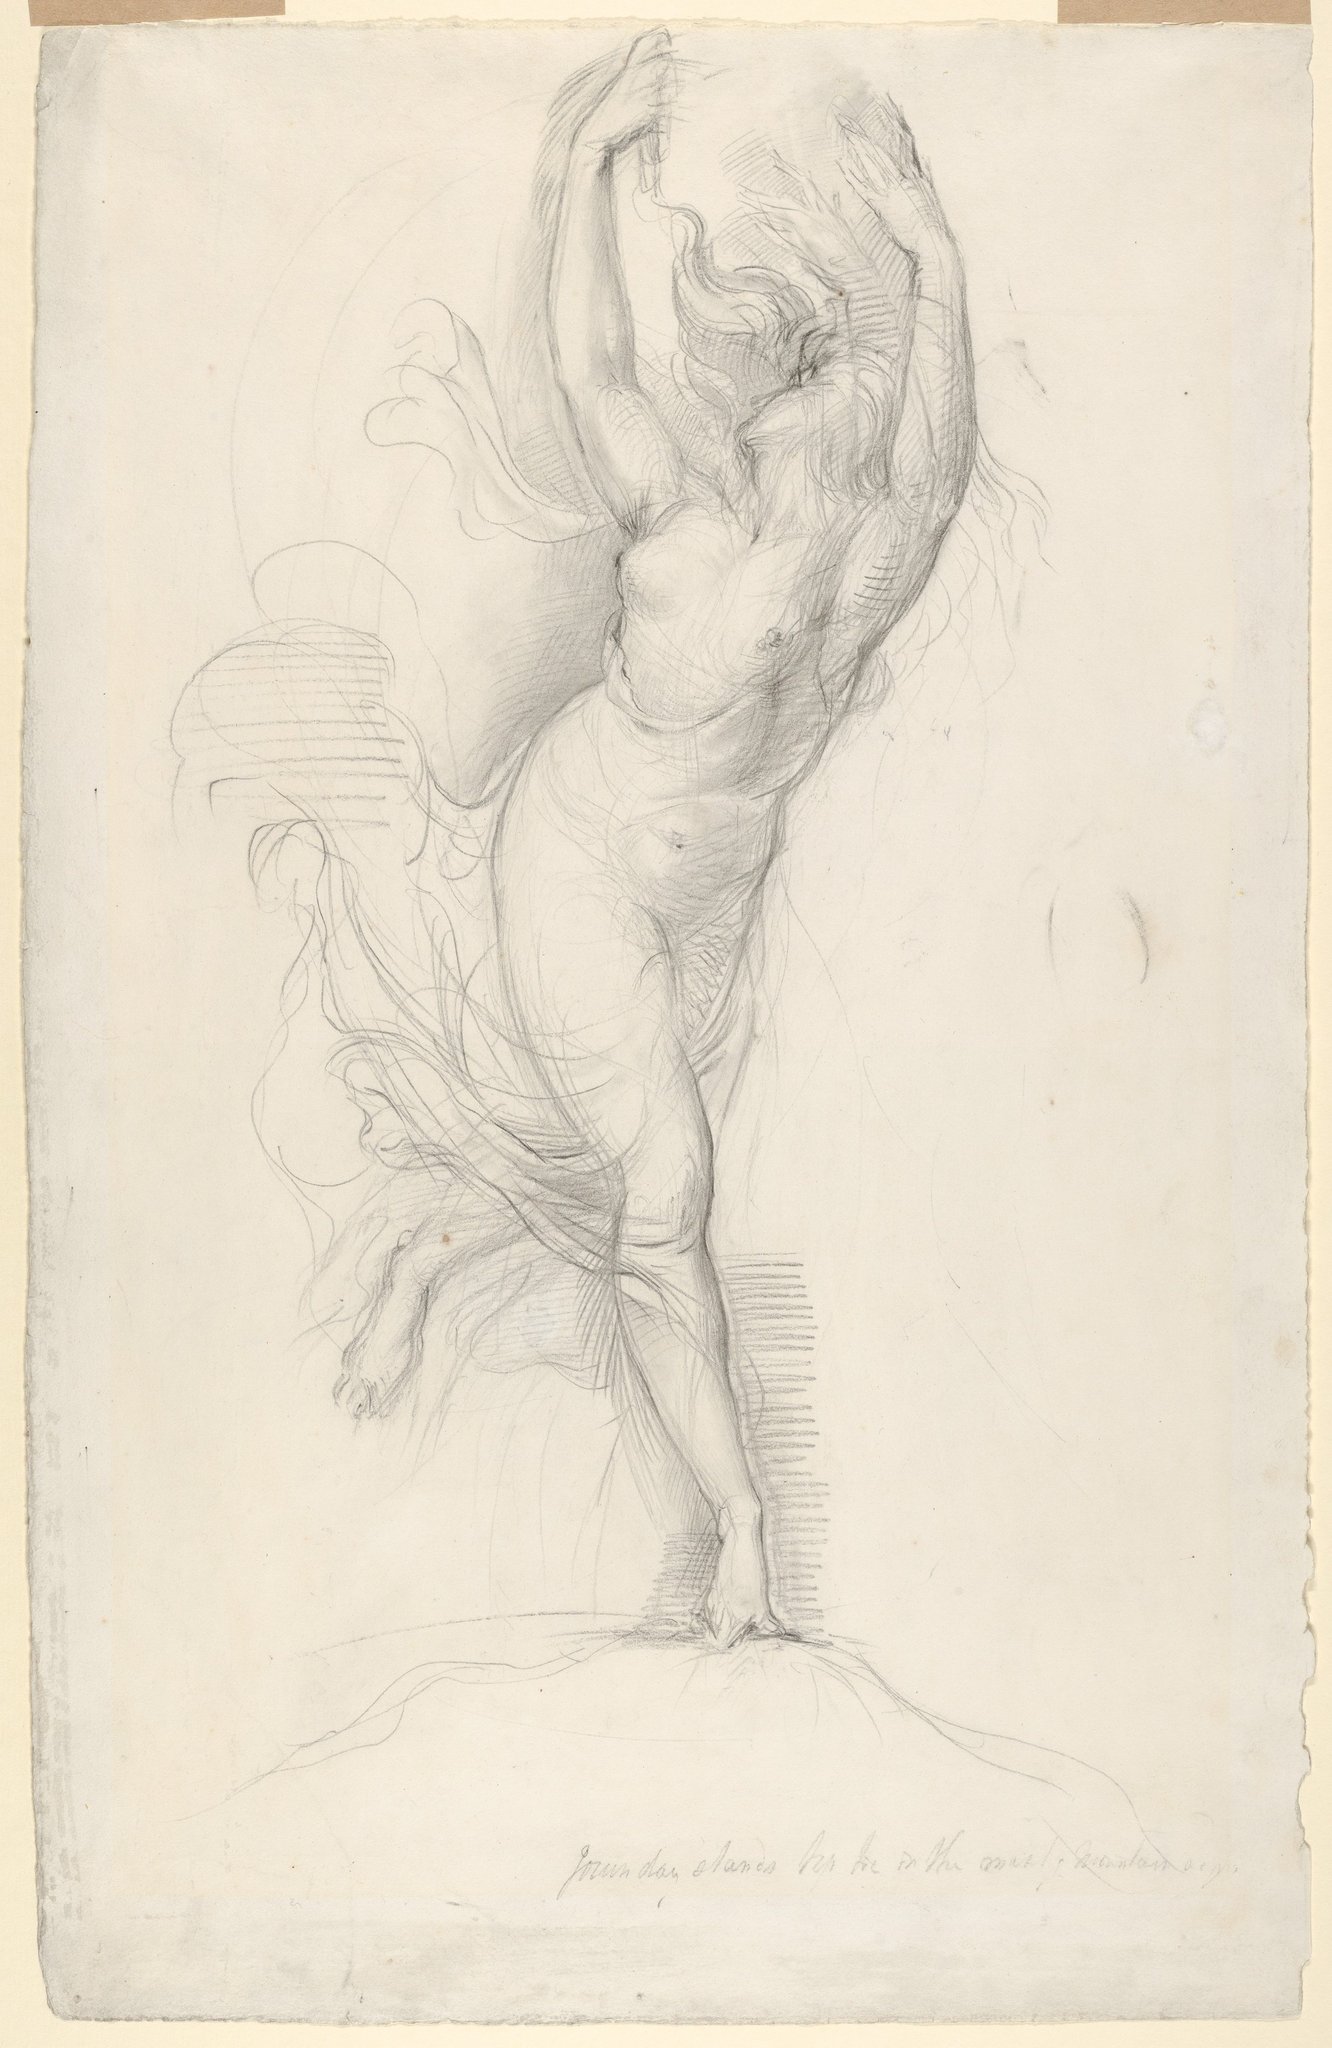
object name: drawing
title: "Jocund Day Stands Tip Toe on the Misty Mountain Tops" (Shakespeare, Romeo and Juliet, Act 3, Scene 5)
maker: george richmond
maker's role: artist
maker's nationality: british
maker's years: 1809-1896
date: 1830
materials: graphite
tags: shakespeare,female nudes